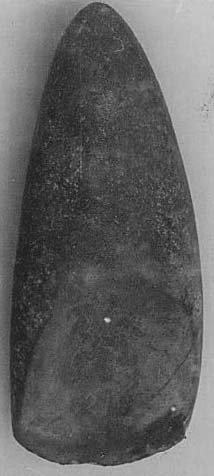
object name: hatchet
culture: french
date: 1902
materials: jade